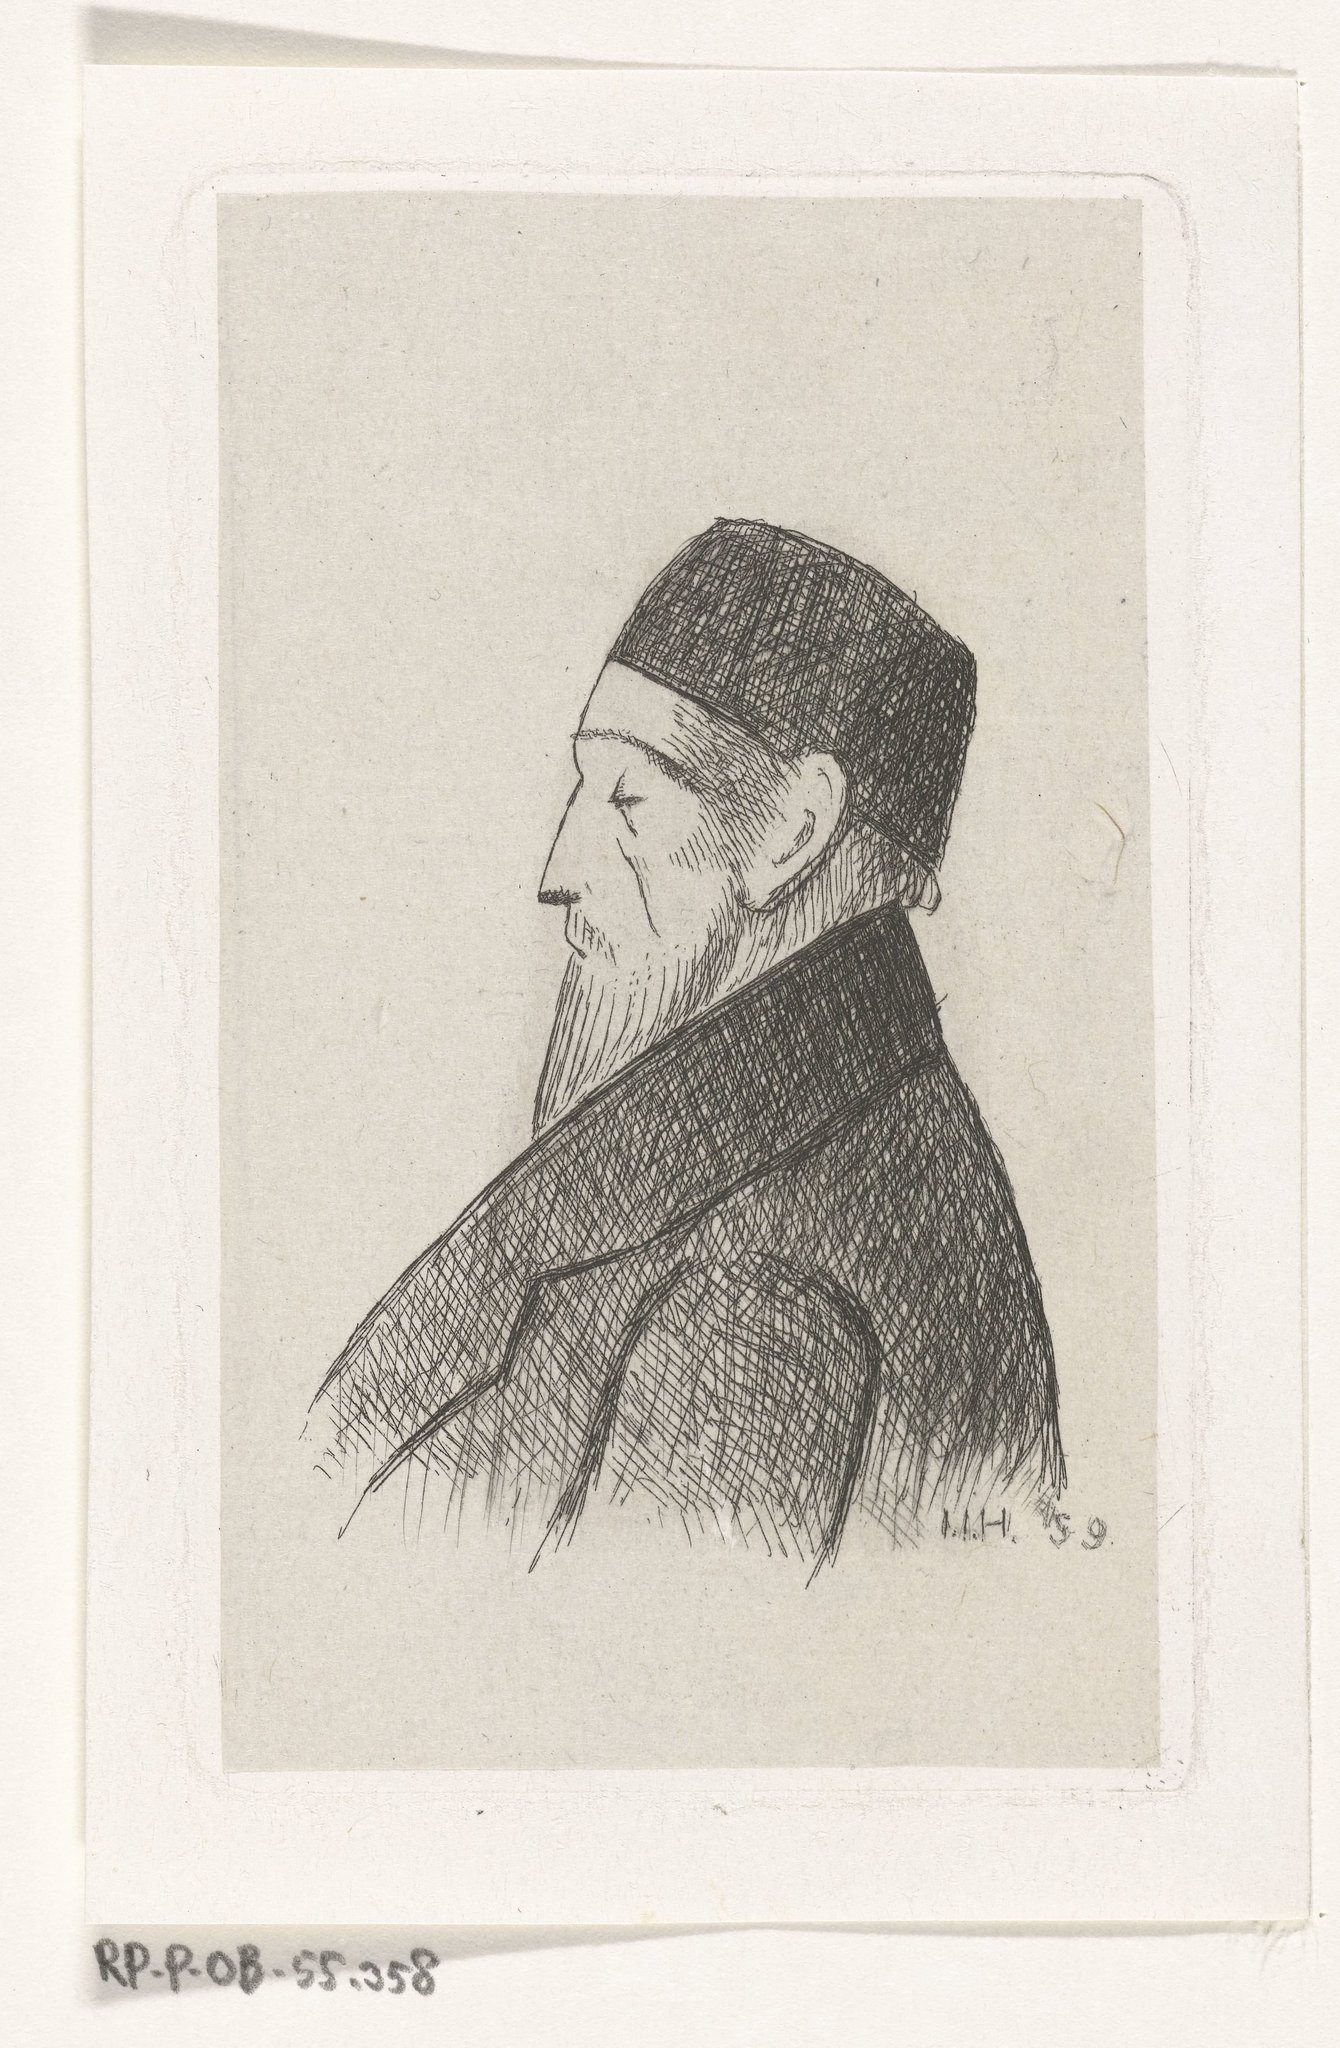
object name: print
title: Portret van Carel August Gunkel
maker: jan heppener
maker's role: print maker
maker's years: 1826-1898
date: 1859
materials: paper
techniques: etching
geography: the hague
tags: the hague, coat (+ men's clothes), beard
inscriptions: collector's mark: Lugt 2228, inscription: ‘portret van generaal Gunkel’